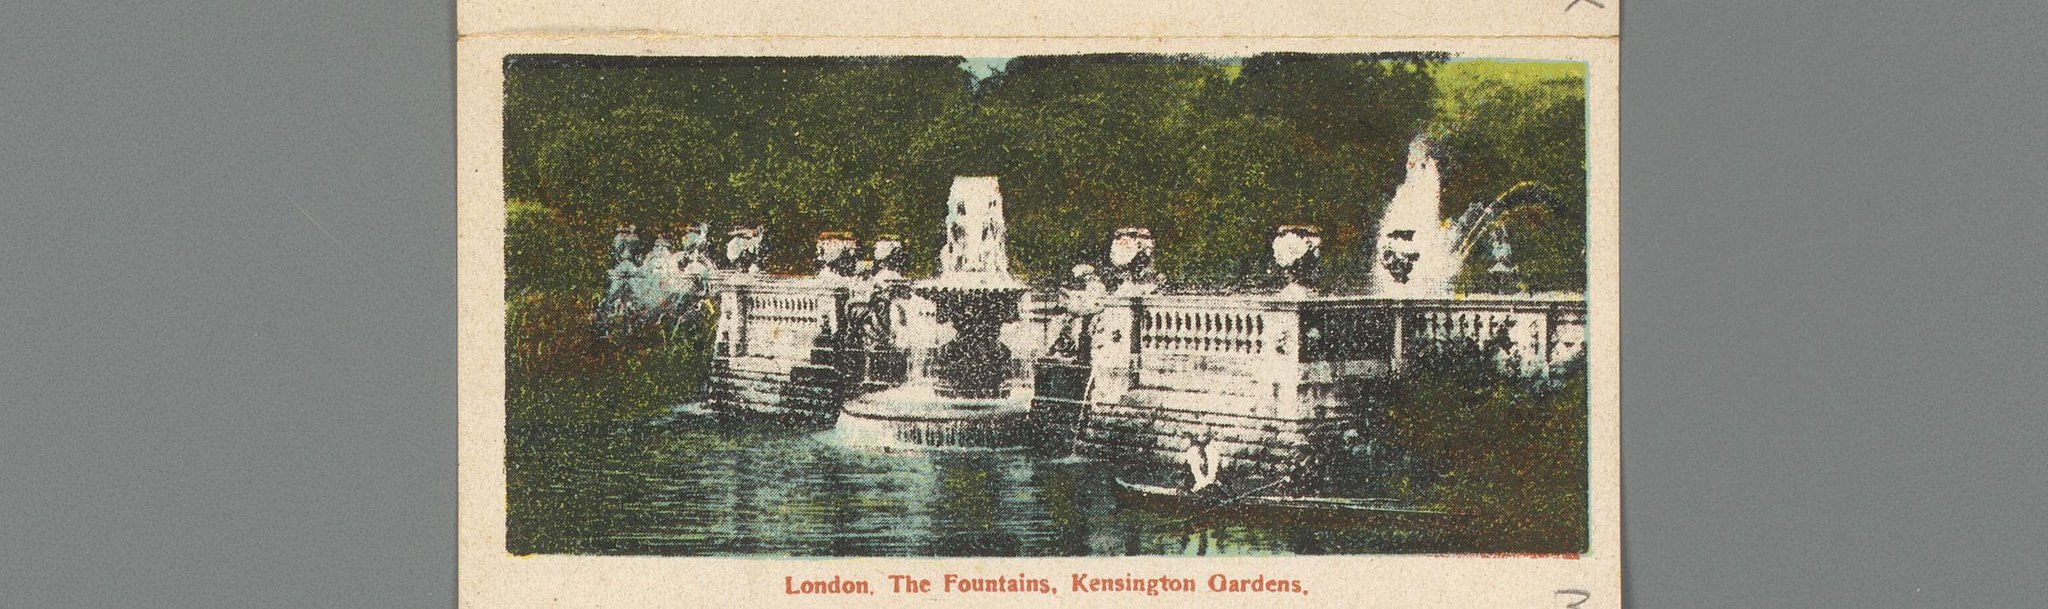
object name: photomechanical print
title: Fonteinen in Kensington Gardens, Londen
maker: Anonymous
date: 1888-1914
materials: paper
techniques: autotype, chromophotolithography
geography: london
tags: ornamental fountain, public gardens, park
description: Deze prent maakt deel uit van een album.